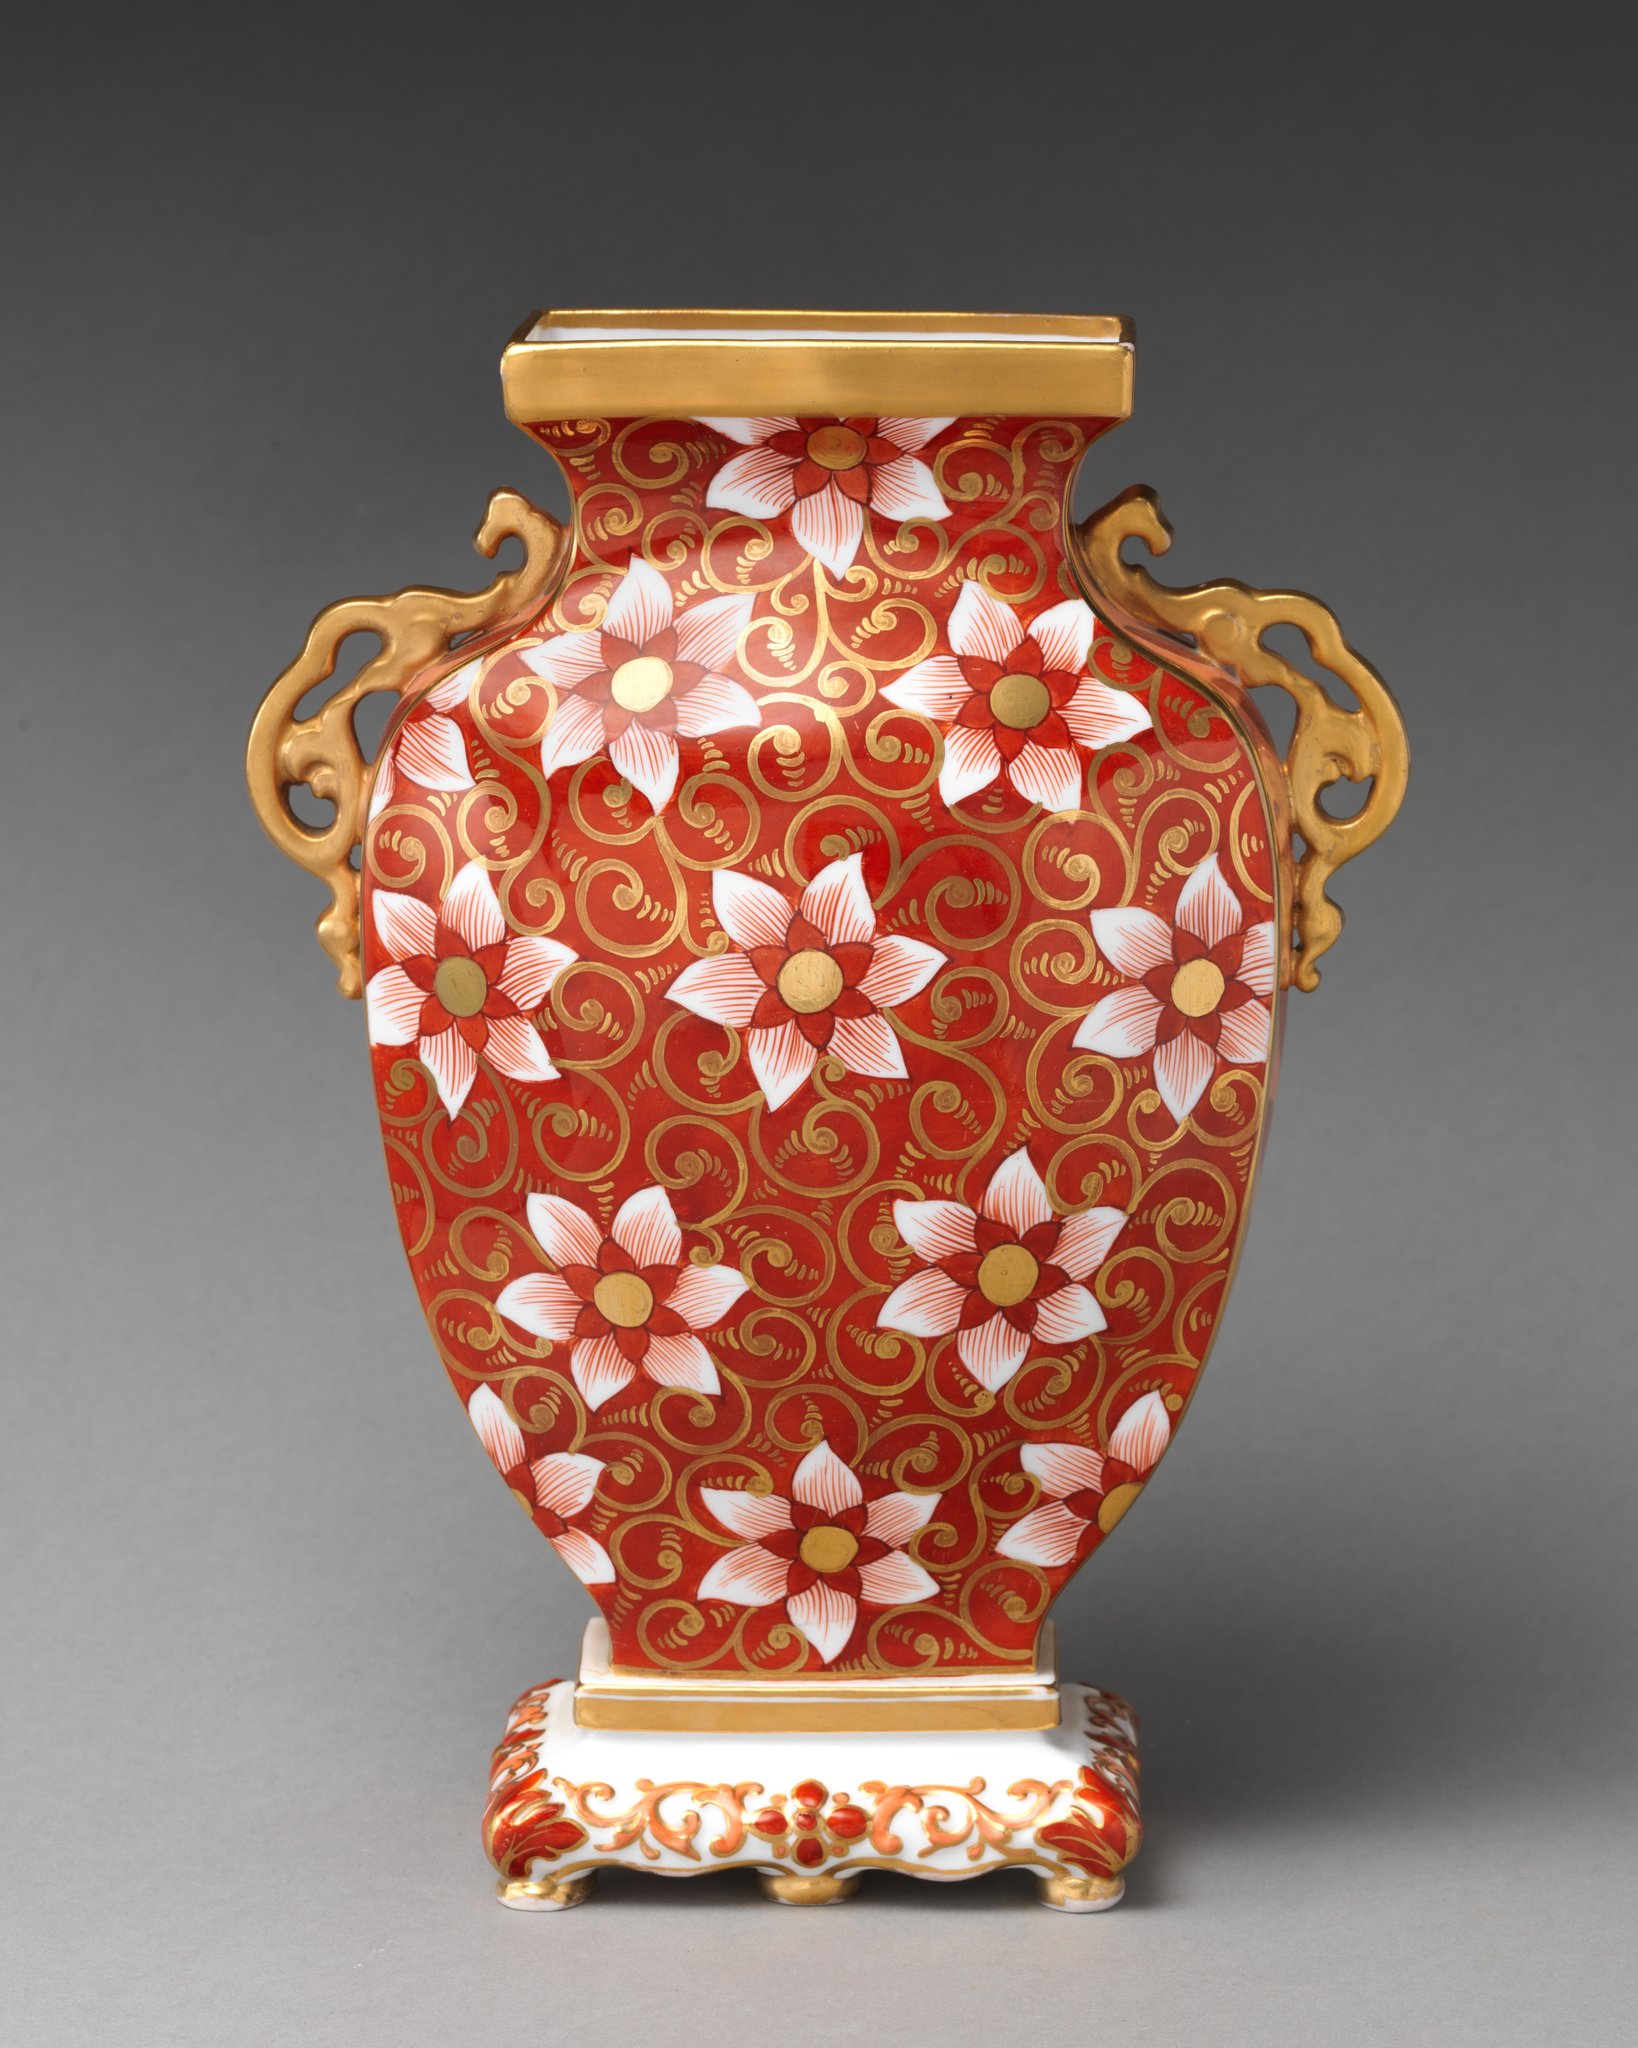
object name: vase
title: Vase (one of a pair)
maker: copeland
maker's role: maker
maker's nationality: british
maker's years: 1833-1970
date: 1891-1900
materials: bone china, enamel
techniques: gilding